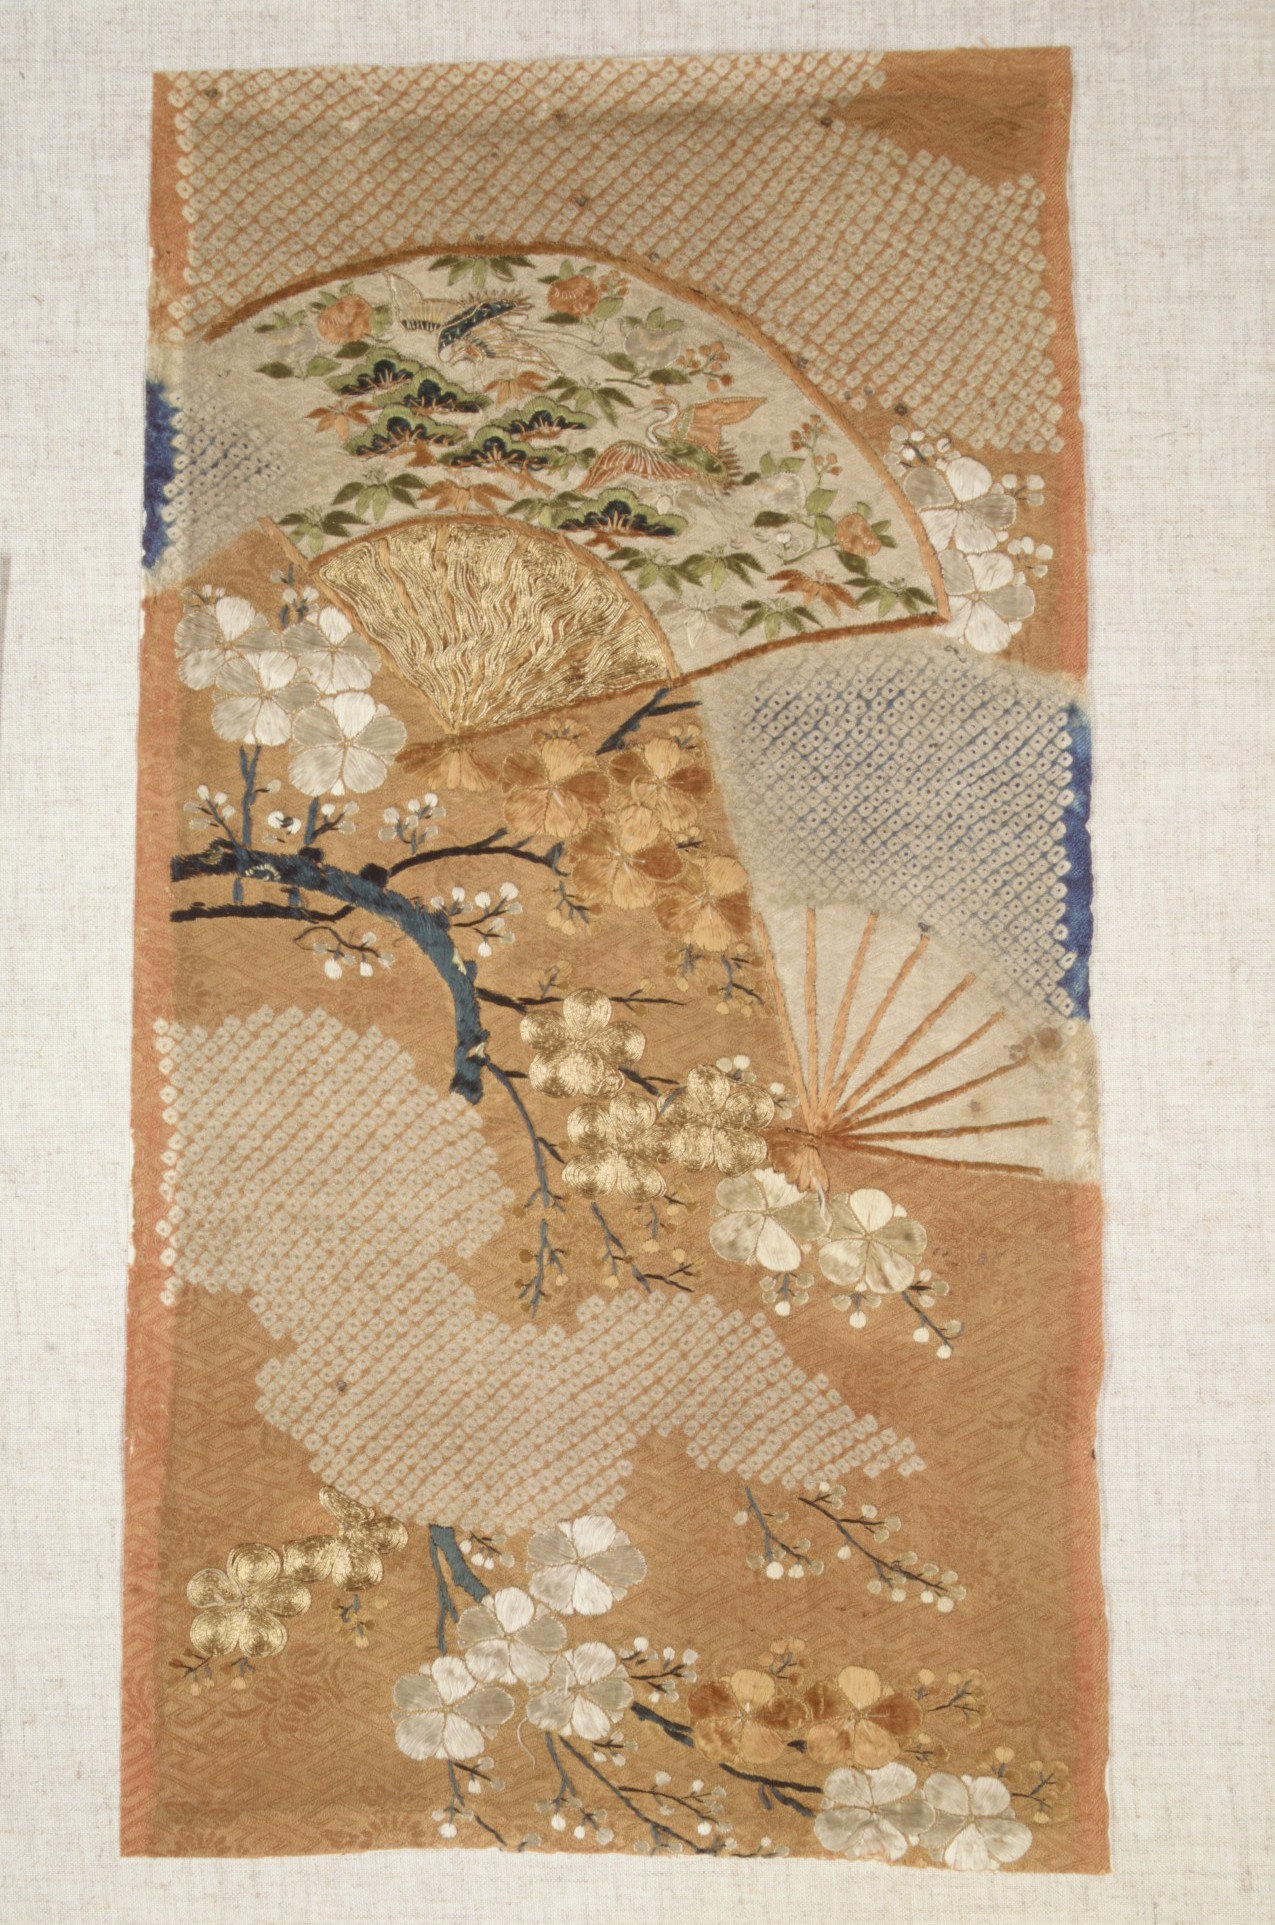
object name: piece from a kosode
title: Kosode Fragment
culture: japanese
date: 1651-1700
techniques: weave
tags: birds,fans